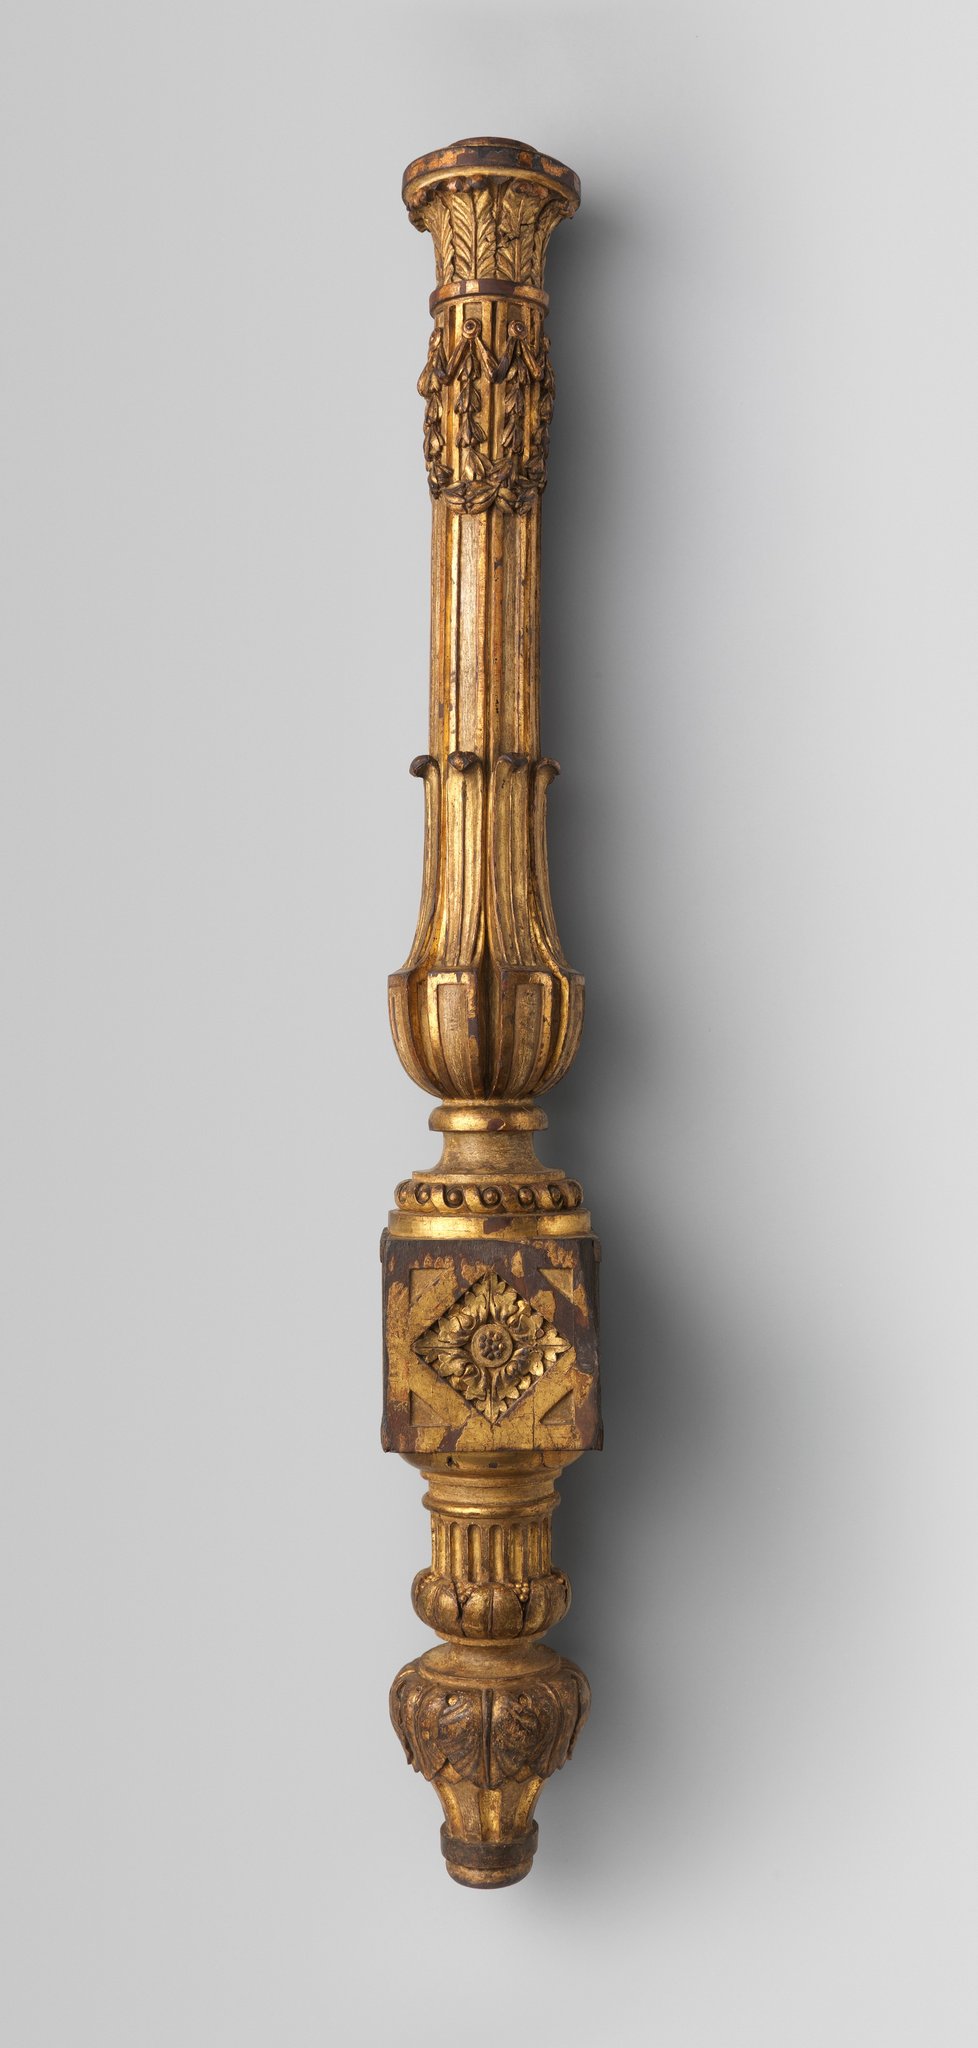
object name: bedstead leg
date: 1701-1800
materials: gilt, wood